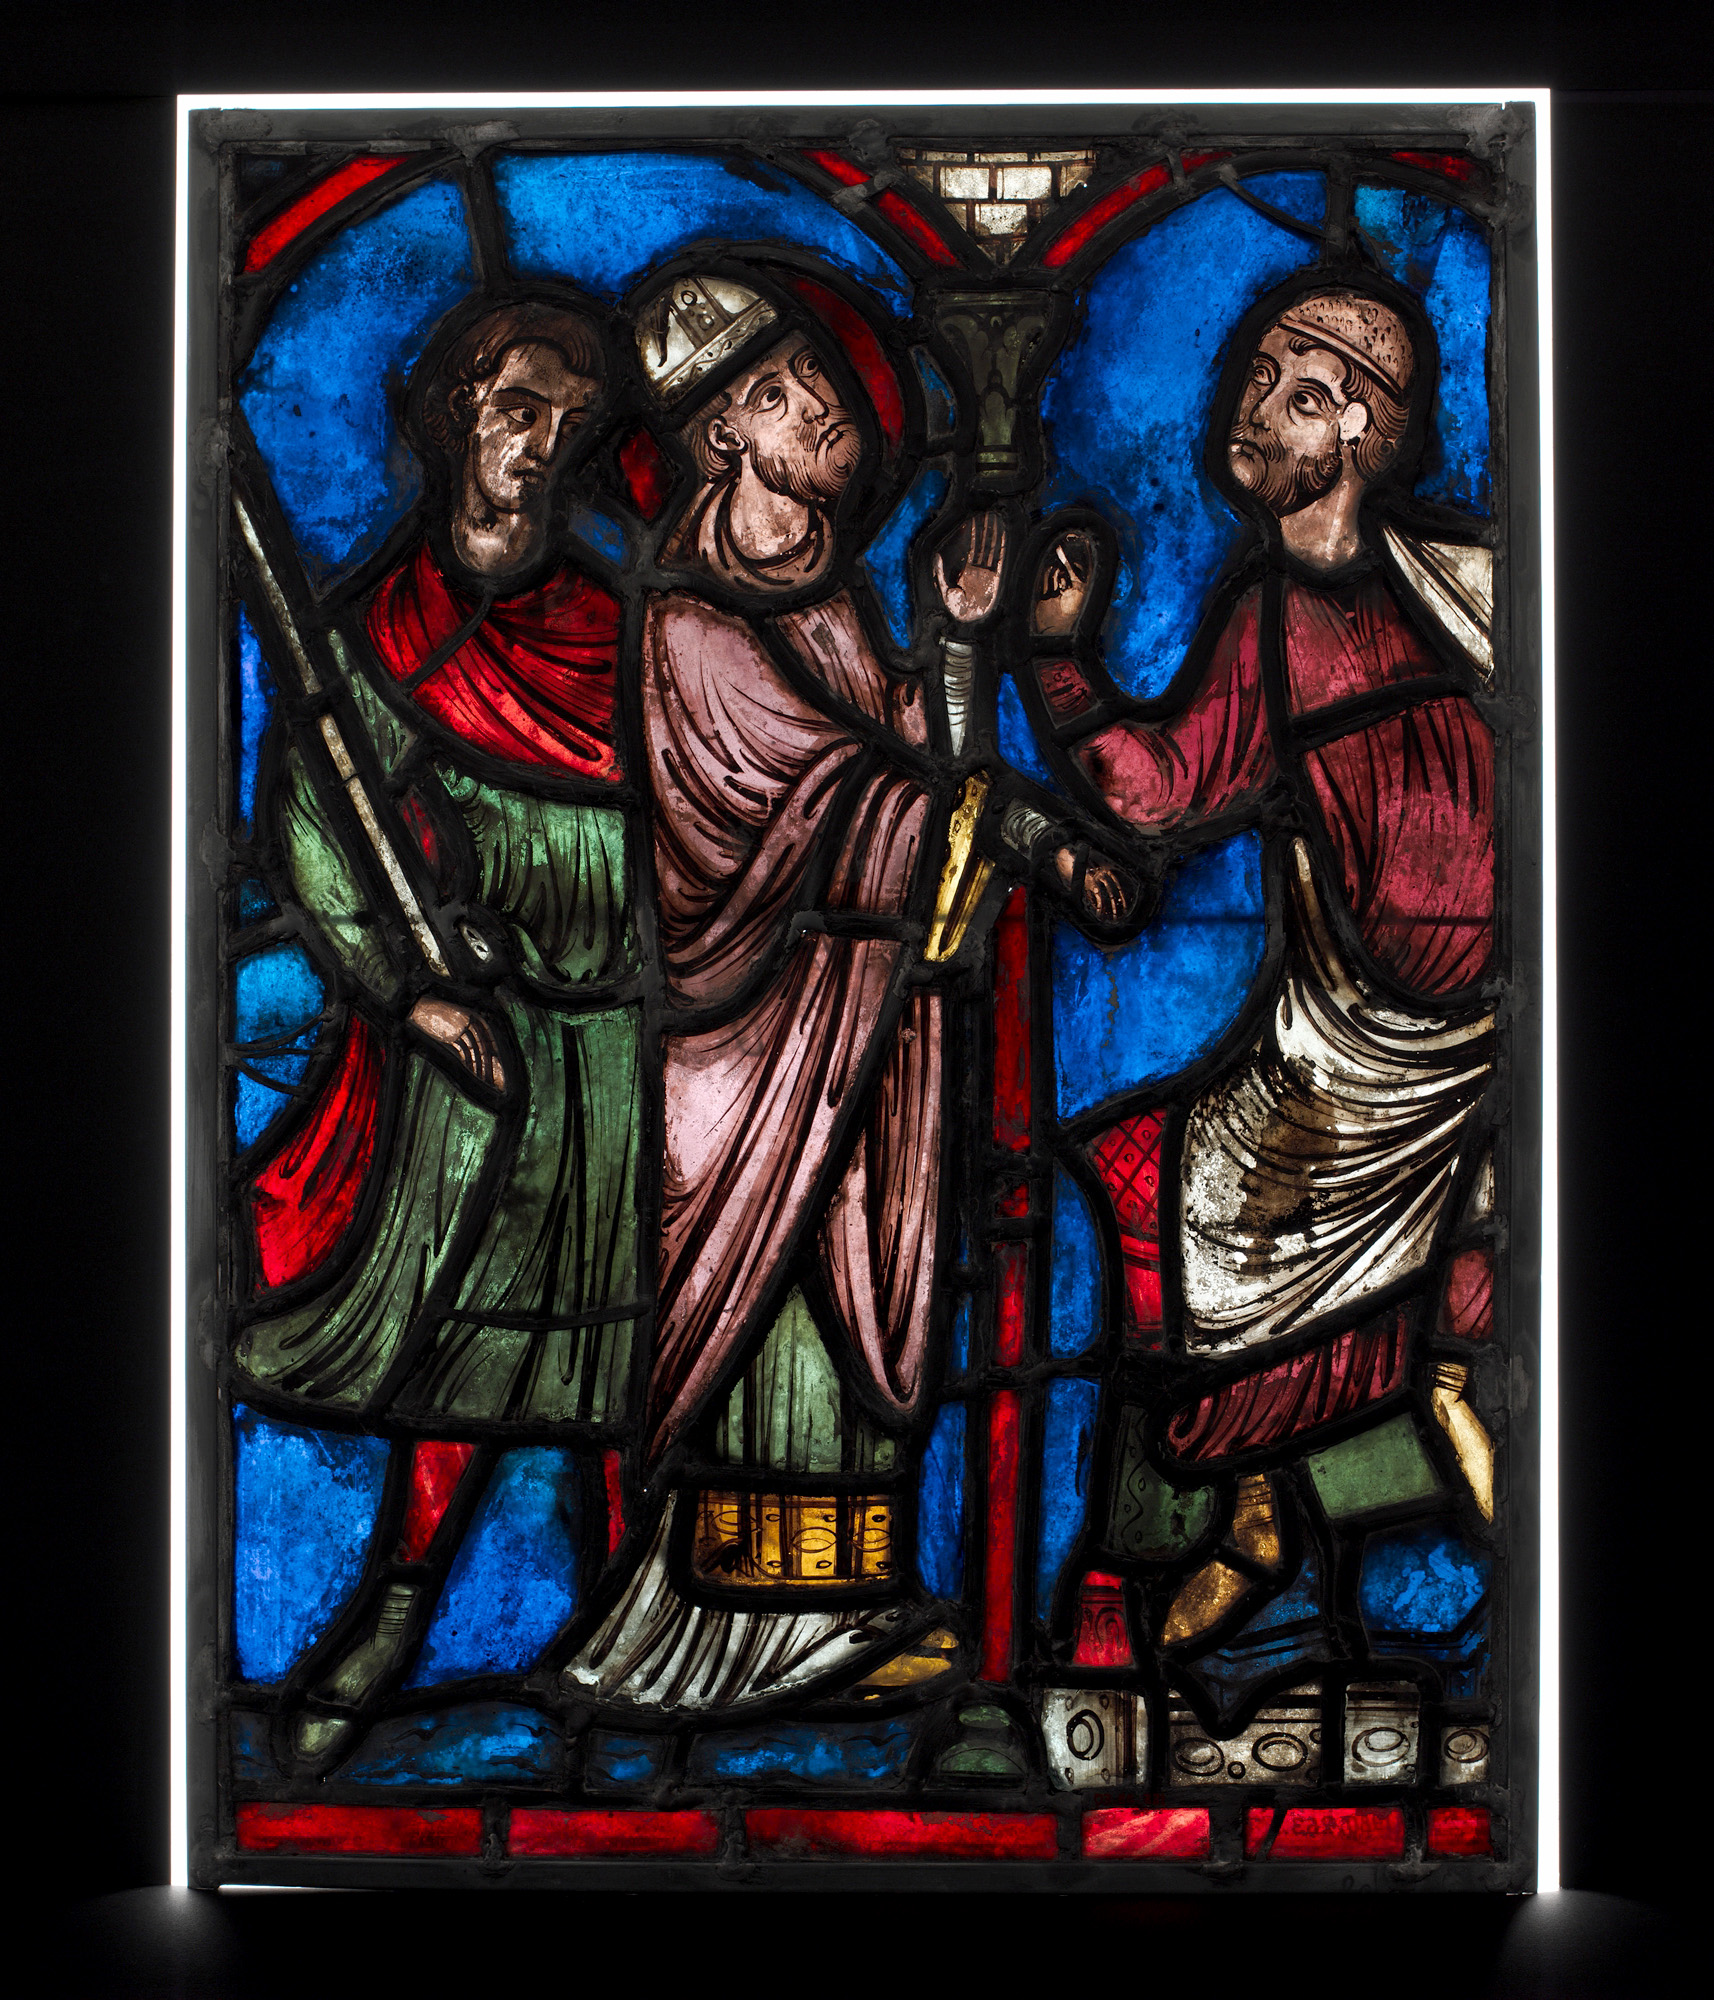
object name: panel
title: Saint Nicholas Accuses the Consul from Scenes from the Life of Saint Nicholas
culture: french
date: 1200-1210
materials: glass, metal, paint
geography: france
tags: men,saints